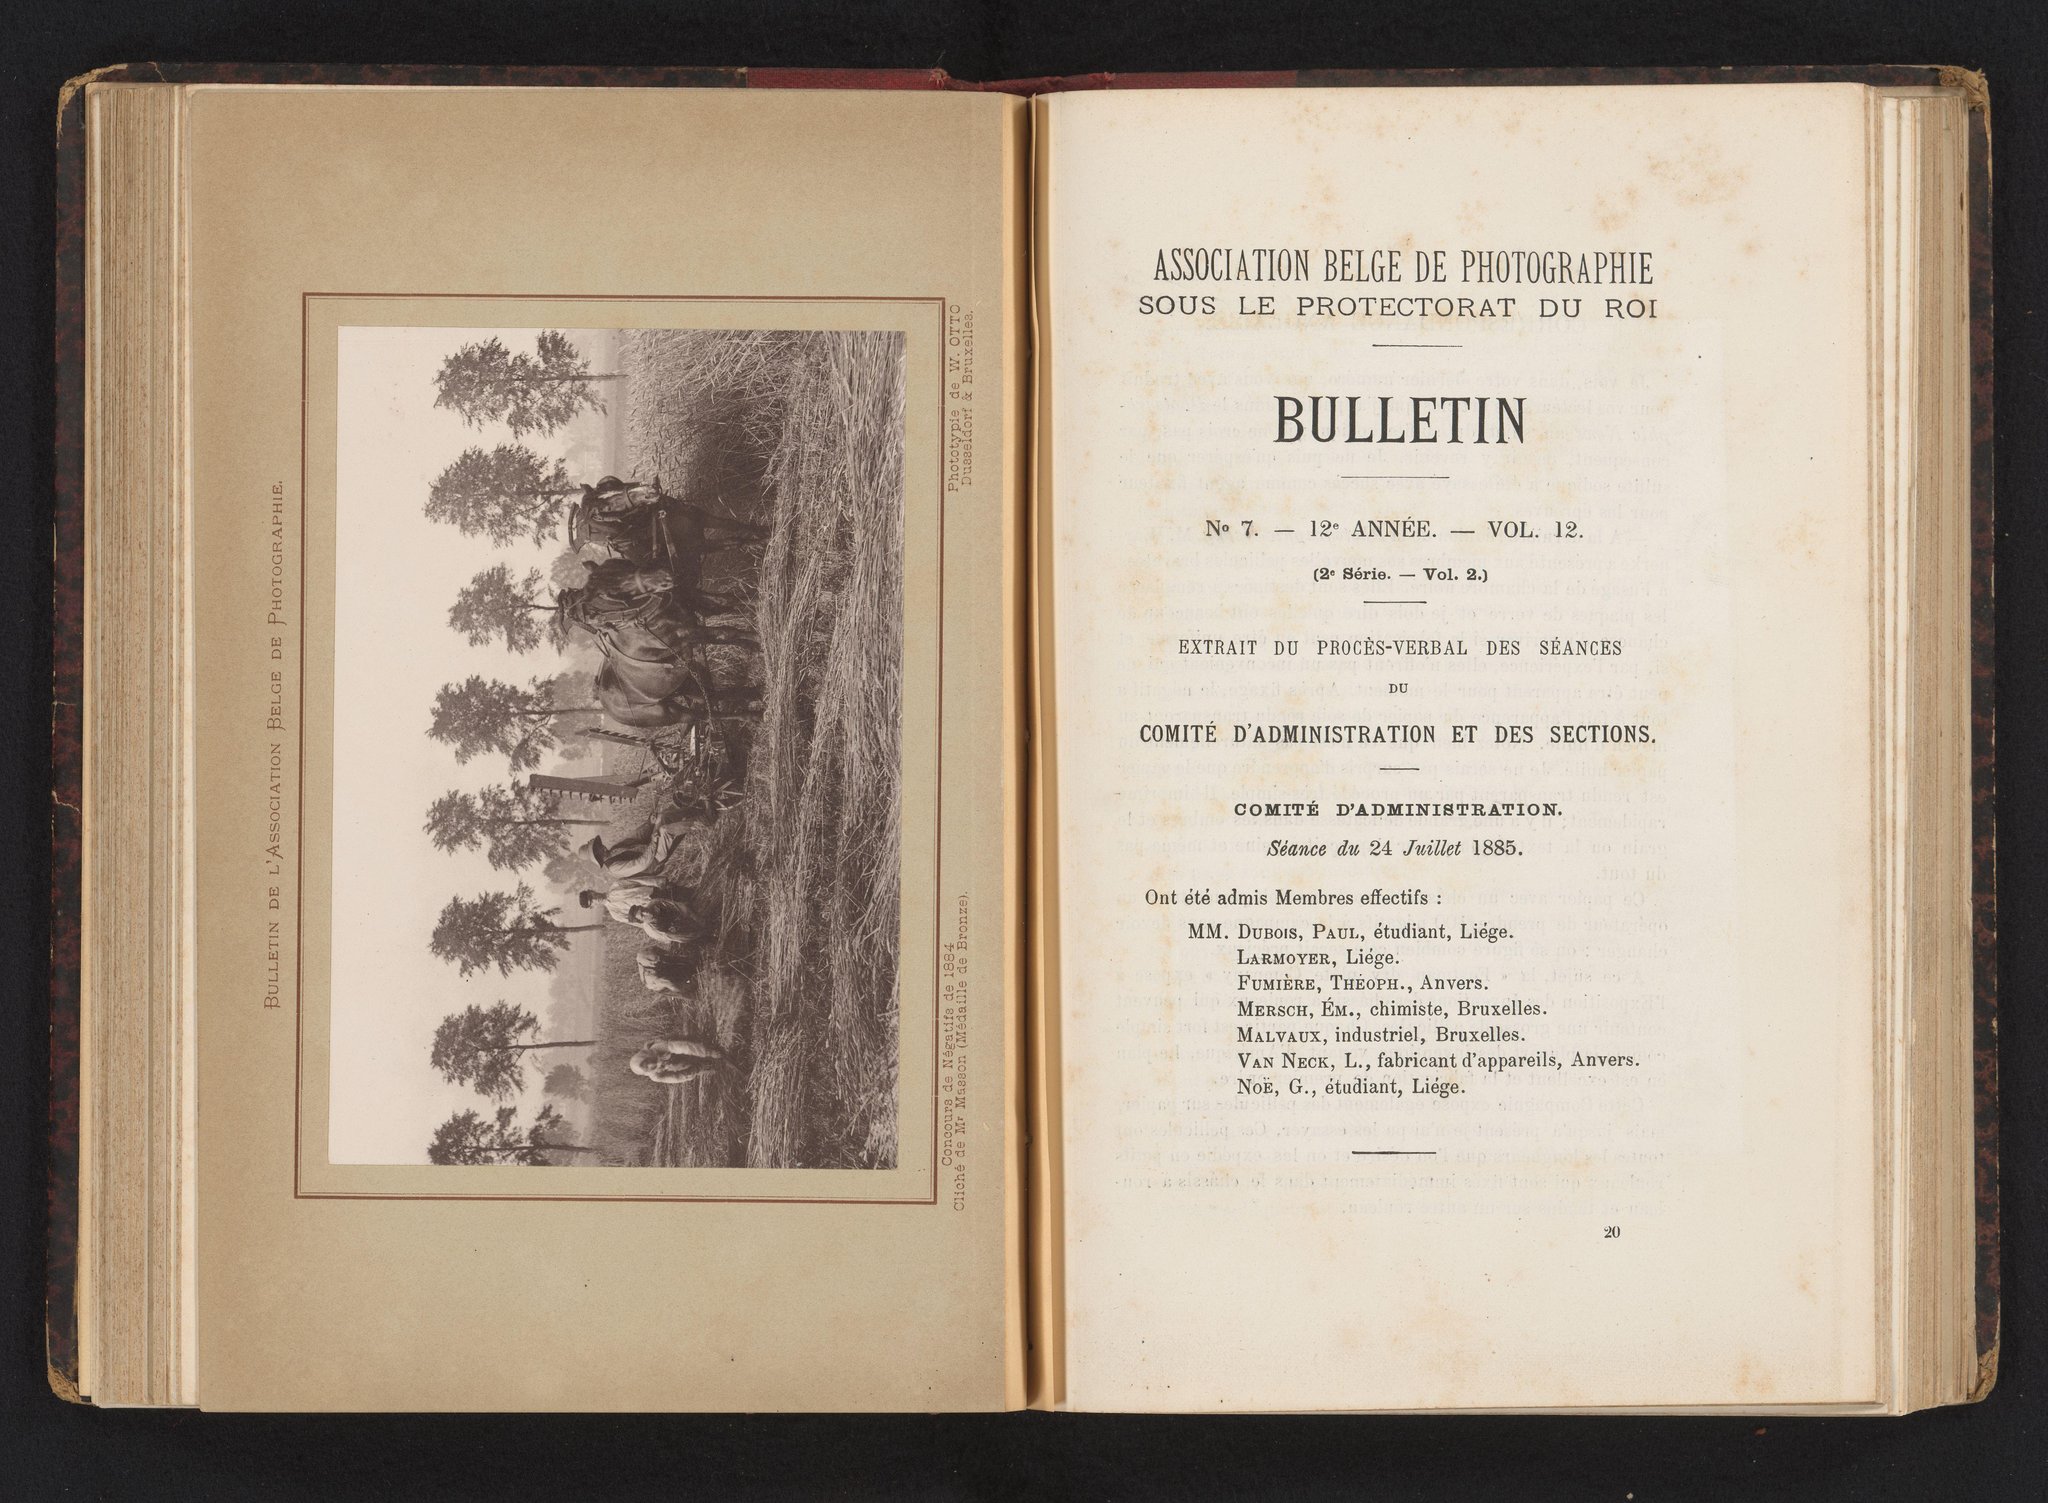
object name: page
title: Boeren met een ploeg door paarden getrokken op het land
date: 1880-1885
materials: paper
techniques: photograph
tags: farmers, horse, agricultural implements: plough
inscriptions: inscription: ‘Bulletin de l'association belge de photographie’, inscription: ‘Concours e Négatifs de 1884.’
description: Prent twee en drie pagina's voor pagina 232.